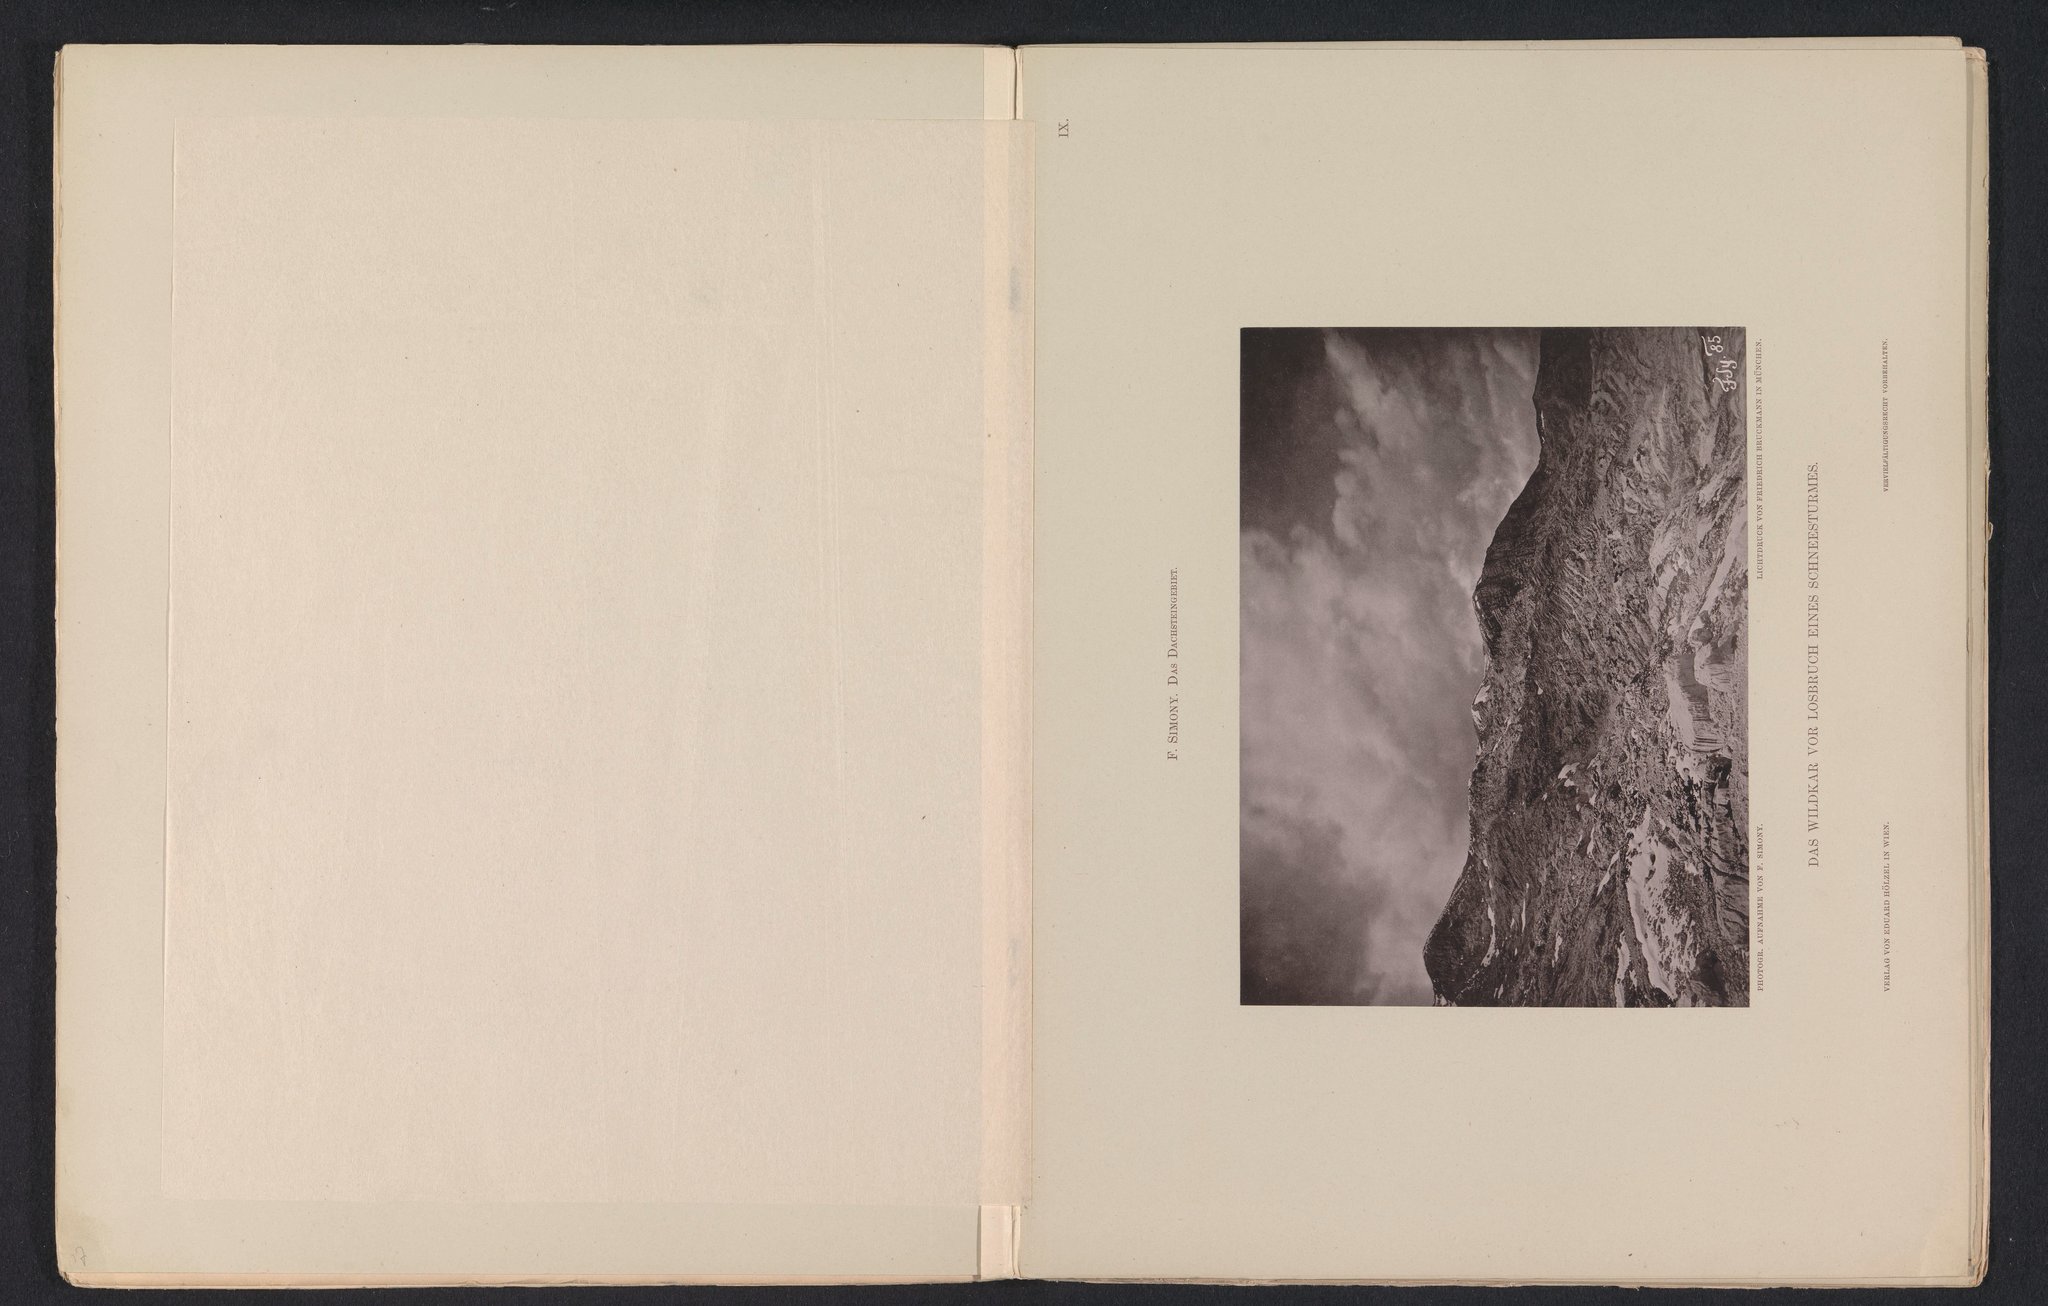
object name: page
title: Gezicht op de Wildkarspitze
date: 1879-1889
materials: paper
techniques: photograph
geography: austria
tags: mountain-top, peak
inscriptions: number: ‘IX.’